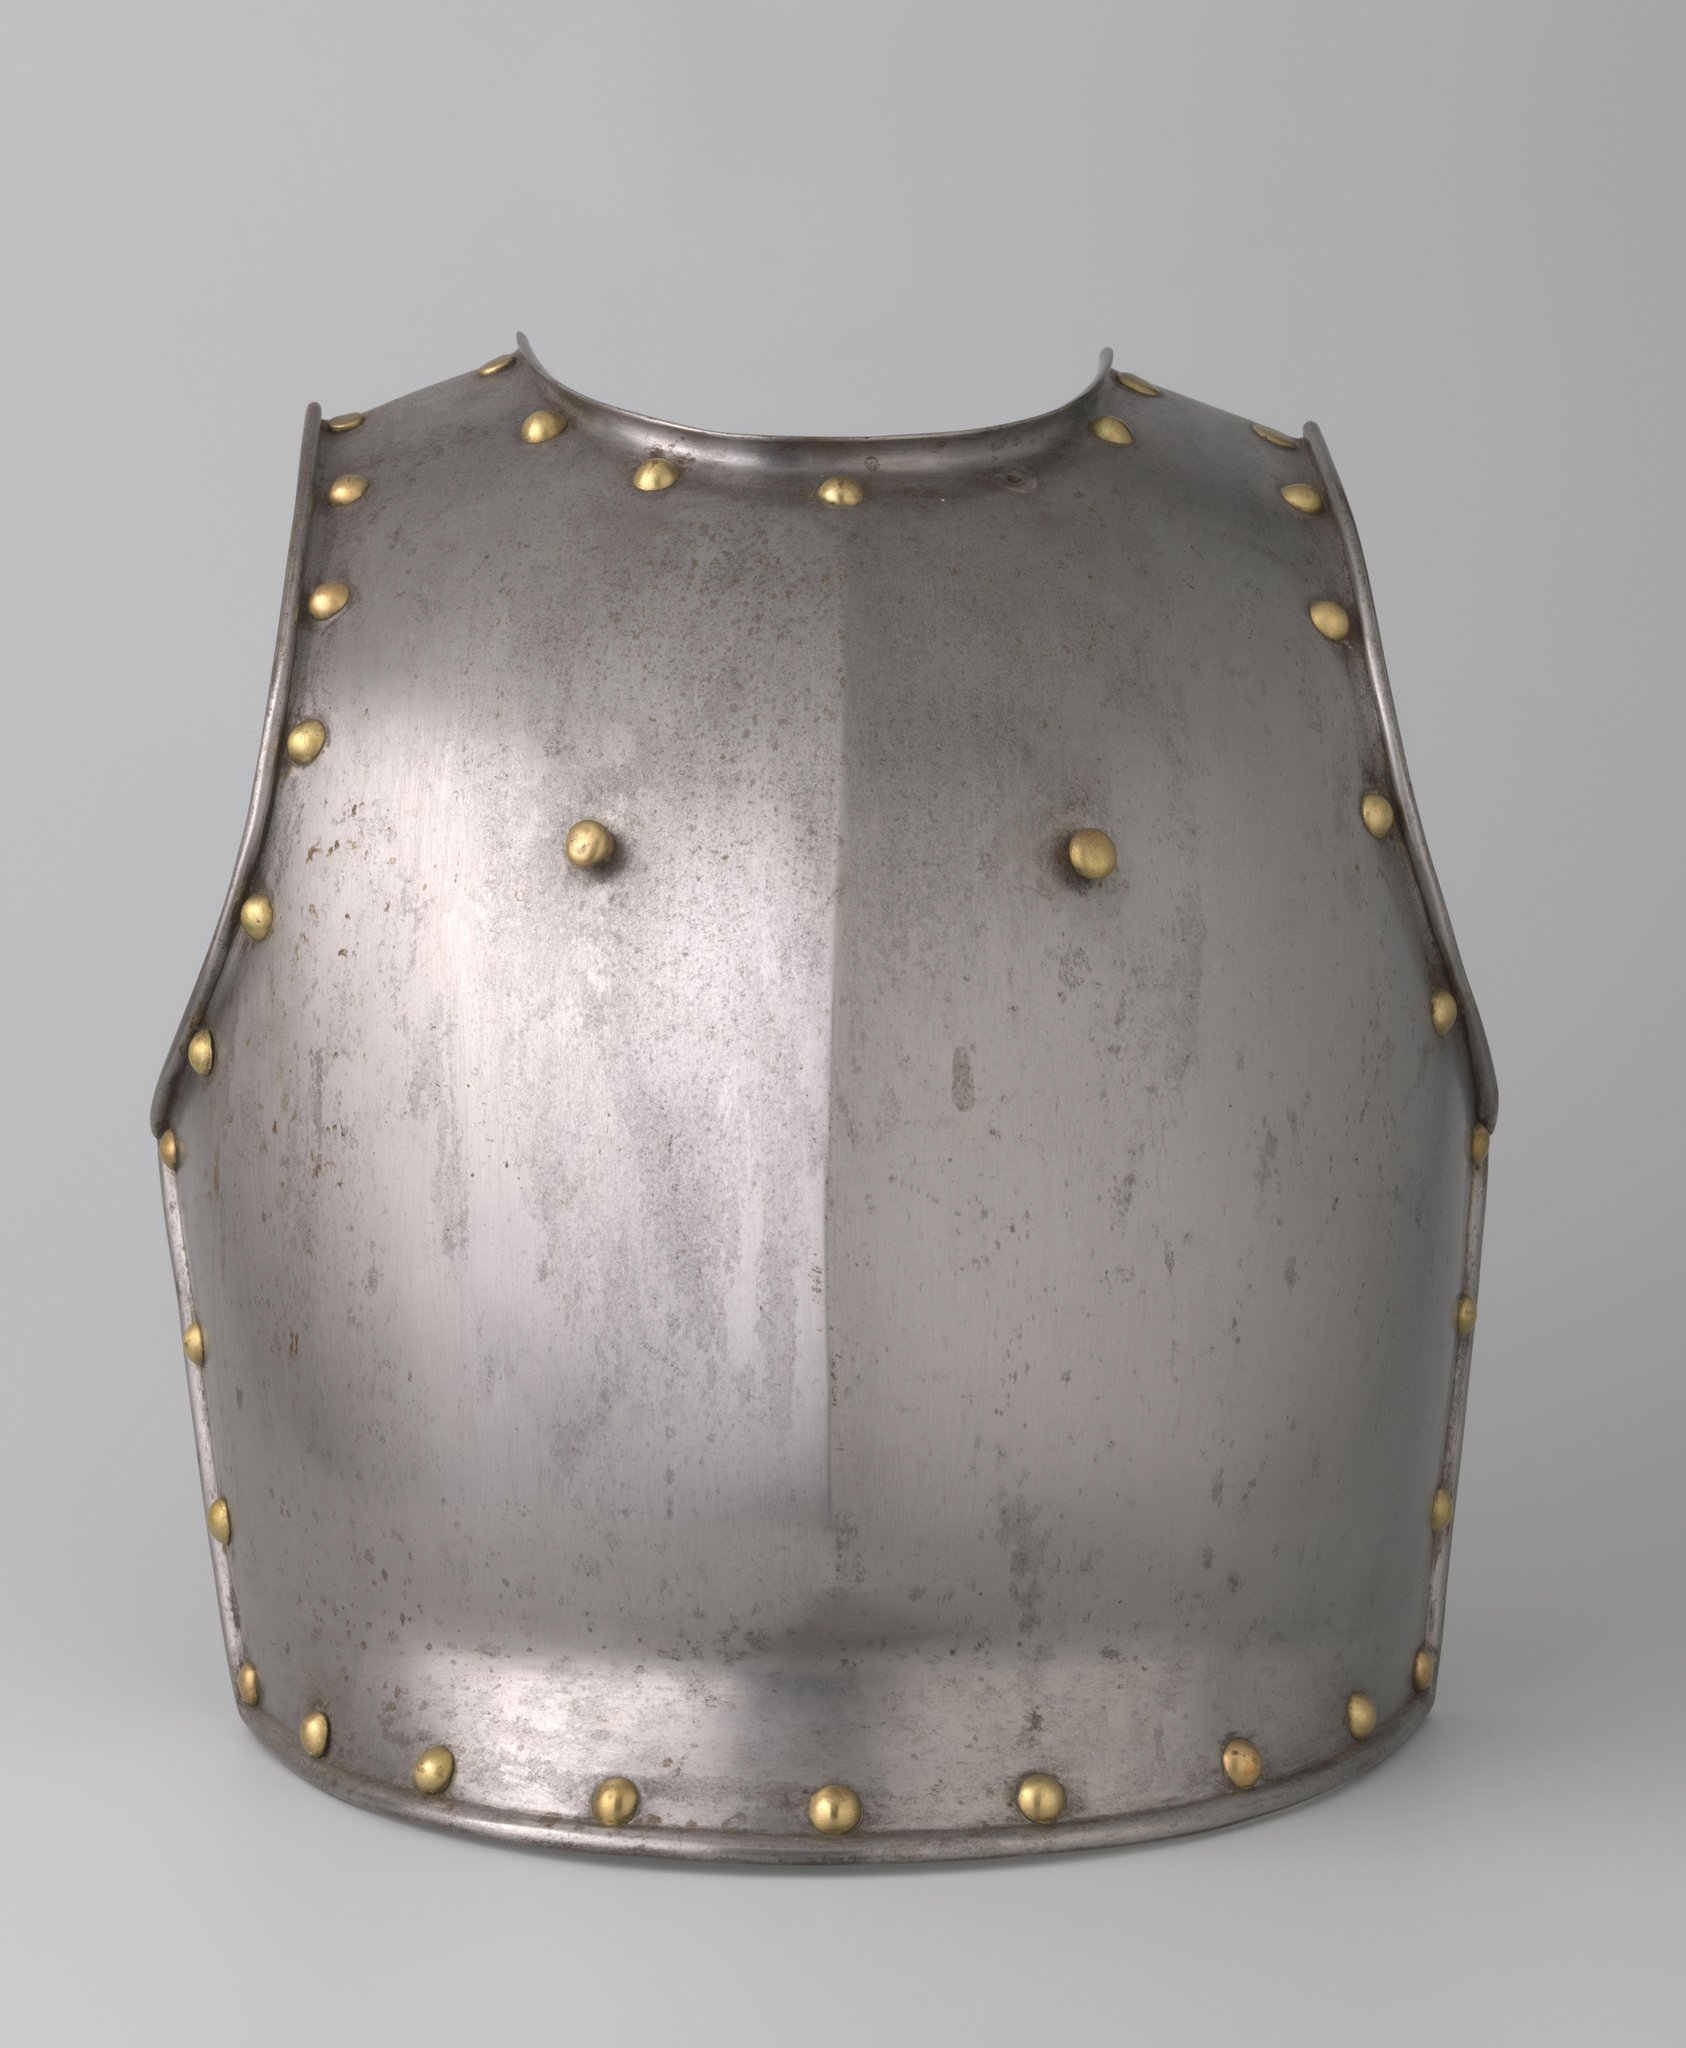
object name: borstlap, maagstuk, borststuk, devant de gorge, plastron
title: Borststuk van kuras voor kurassier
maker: Anonymous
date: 1810-1830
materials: copper, iron, leather, linen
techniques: forging, weave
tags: netherlands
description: IJzeren borstvormig stuk met hals- en armopeningen, randen verstevigd. Rondom afgezet met koperen nagels. Op de borst zijn twee knopen gemonteerd. Binnenzijde van kuras in bruin geschilderd. Enkele restanten van de linnen voering en leertjes zichtbaar.